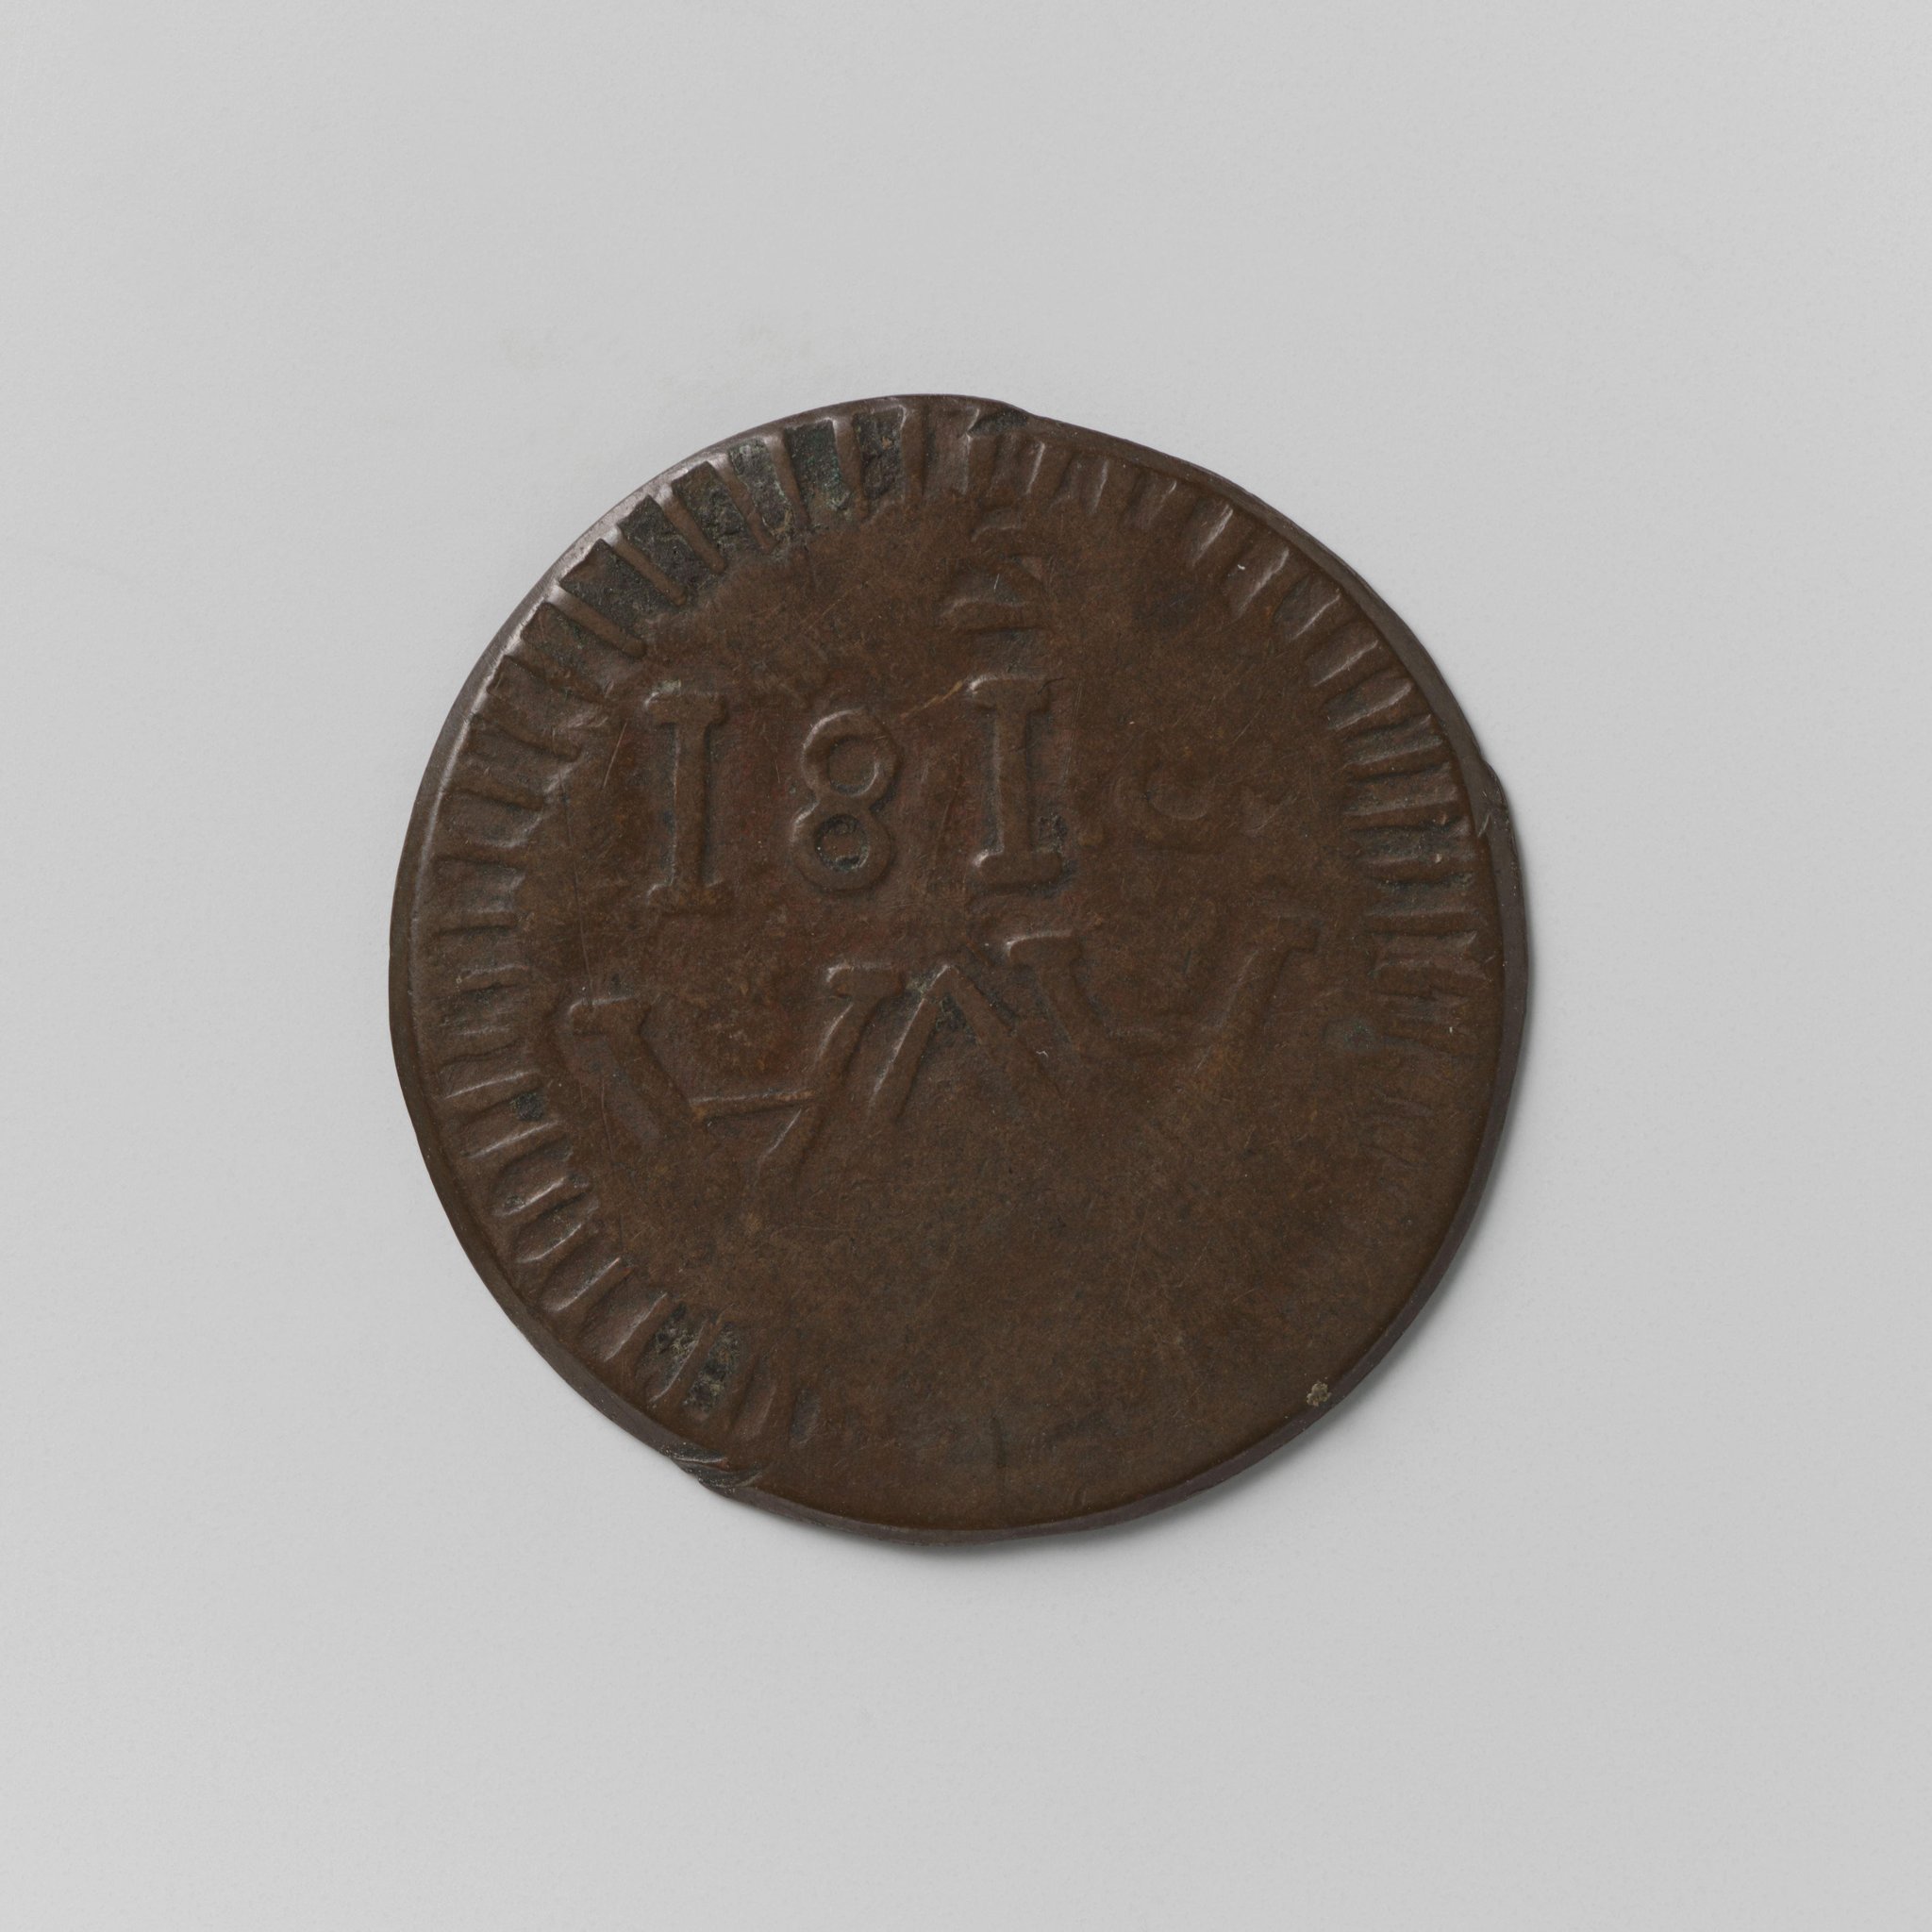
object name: coin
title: Nabootsing uit Zuid-Borneo van een 1/2 stuiver voor Nederlands Indië tijdens Brits bestuur, 1813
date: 1813-1820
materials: copper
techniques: striking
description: Koperen munt. Voorzijde: imitatie van: tussen waarde-aanduiding 1/2 St monogram van de Engelse Oostindische Compagnie. Daarboven letter b. Keerzijde: eenregelig opschrift, waaronder jaartal. Boven opschrift geïmiteerd muntteken en onder jaartal geïmiteerd muntmeesterteken.